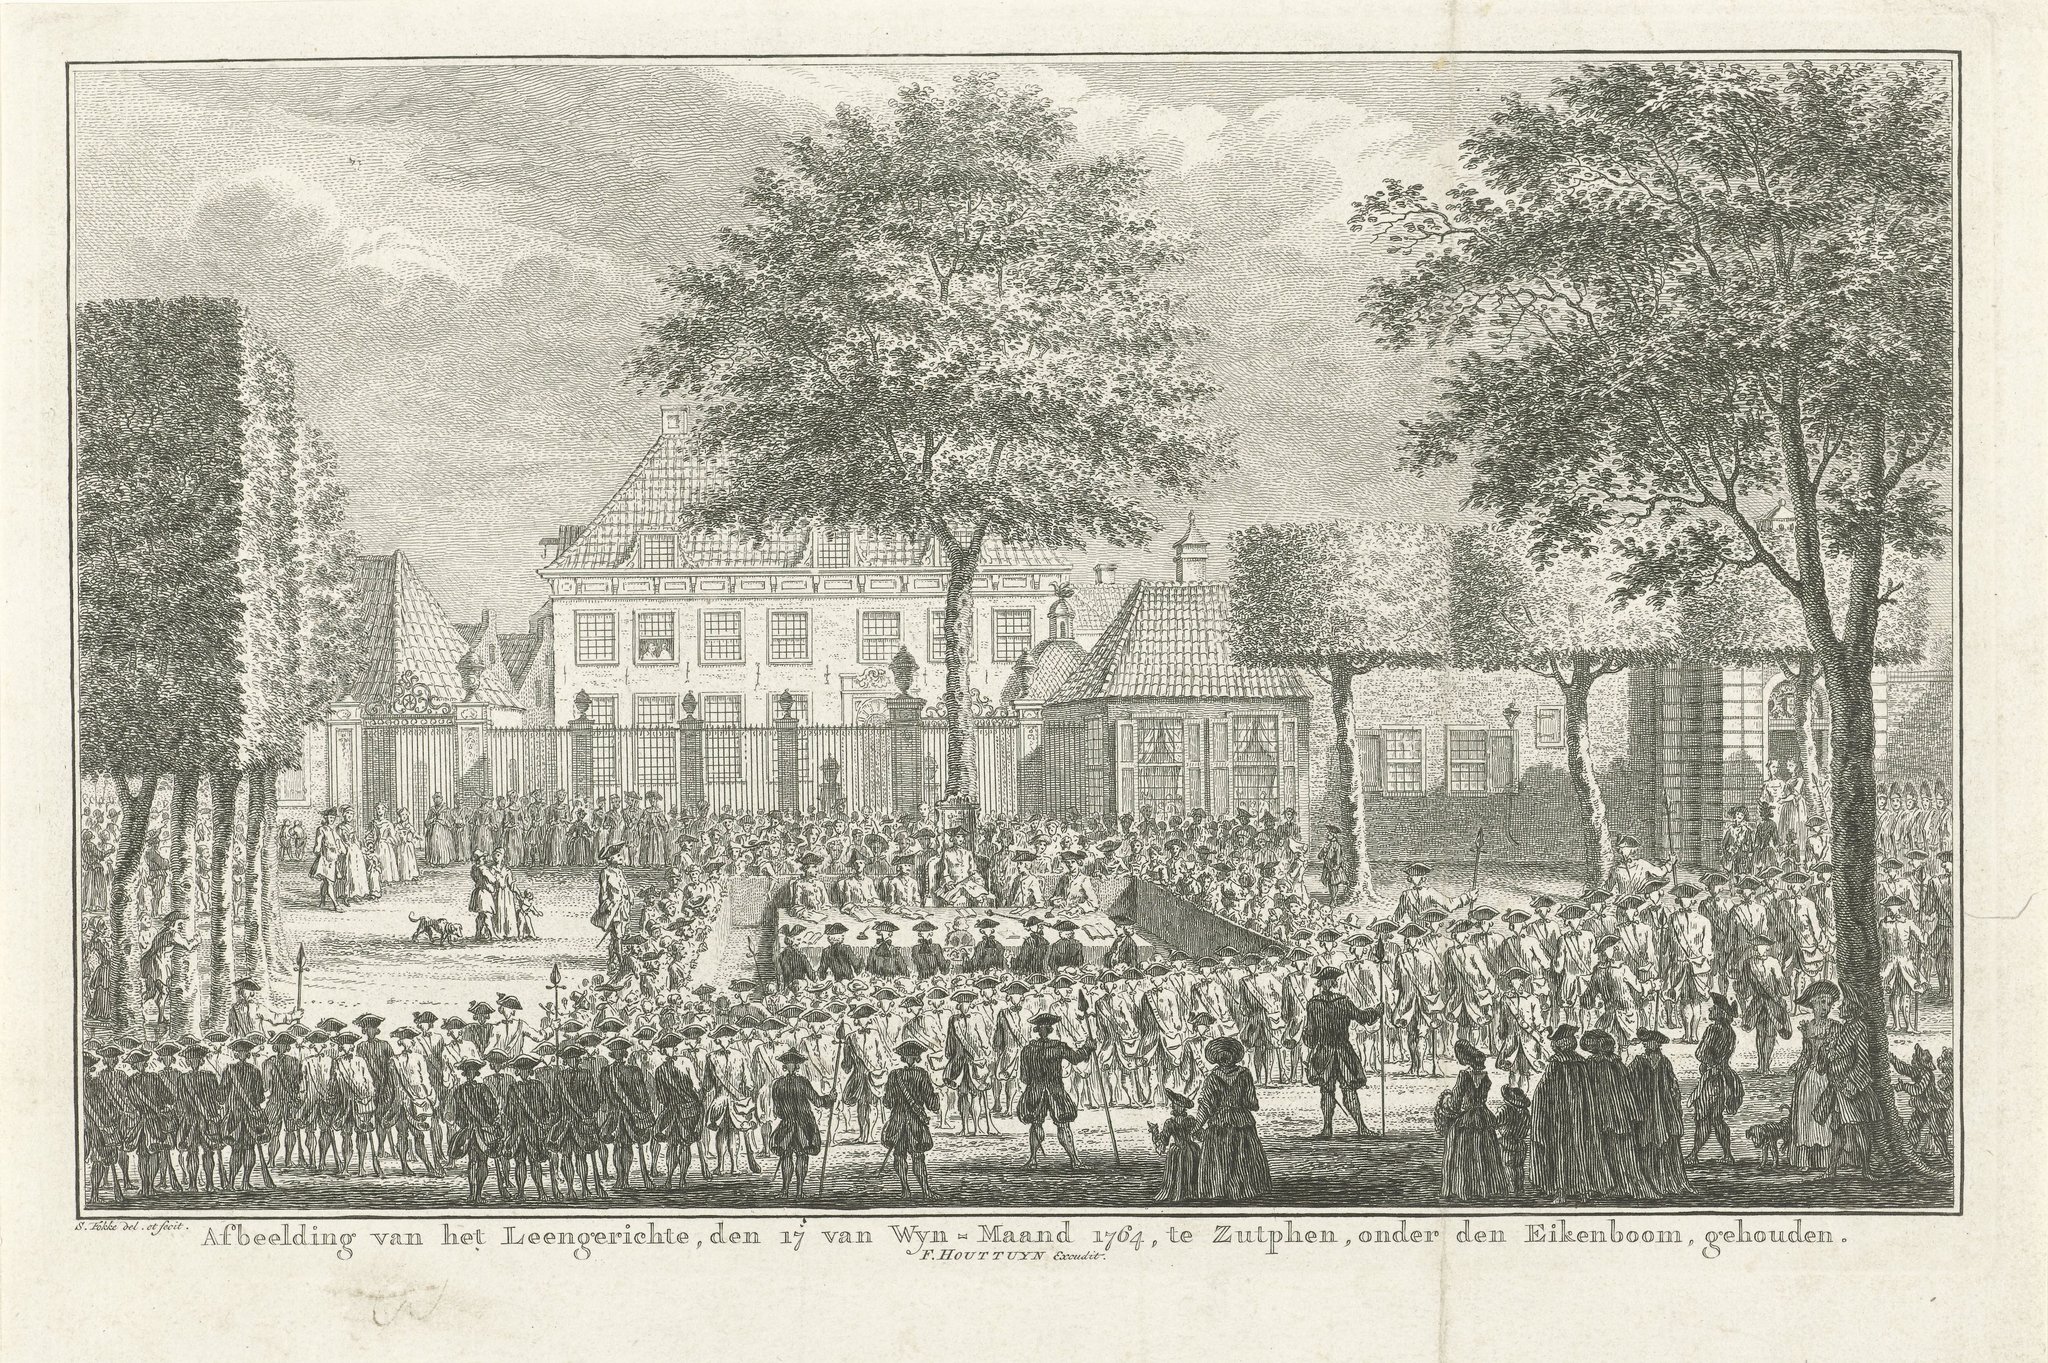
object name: print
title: Leengerecht te Zutphen, 1764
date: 1764-1766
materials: paper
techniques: etching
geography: northern netherlands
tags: law and jurisprudence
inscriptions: collector's mark: Lugt 2228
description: Bijeenkomst van het leengerecht in de open lucht onder de eik, 17 oktober 1764. Te midden van het 's Gravenhof te Zutphen zitten leden van het gerechtshof voor leenzaken aan een tafel. Burgers en leden van de schutterij hebben zich rondom de met een omheining afgeschermde tafel opgesteld om deze bijeenkomst te kunnen volgen.